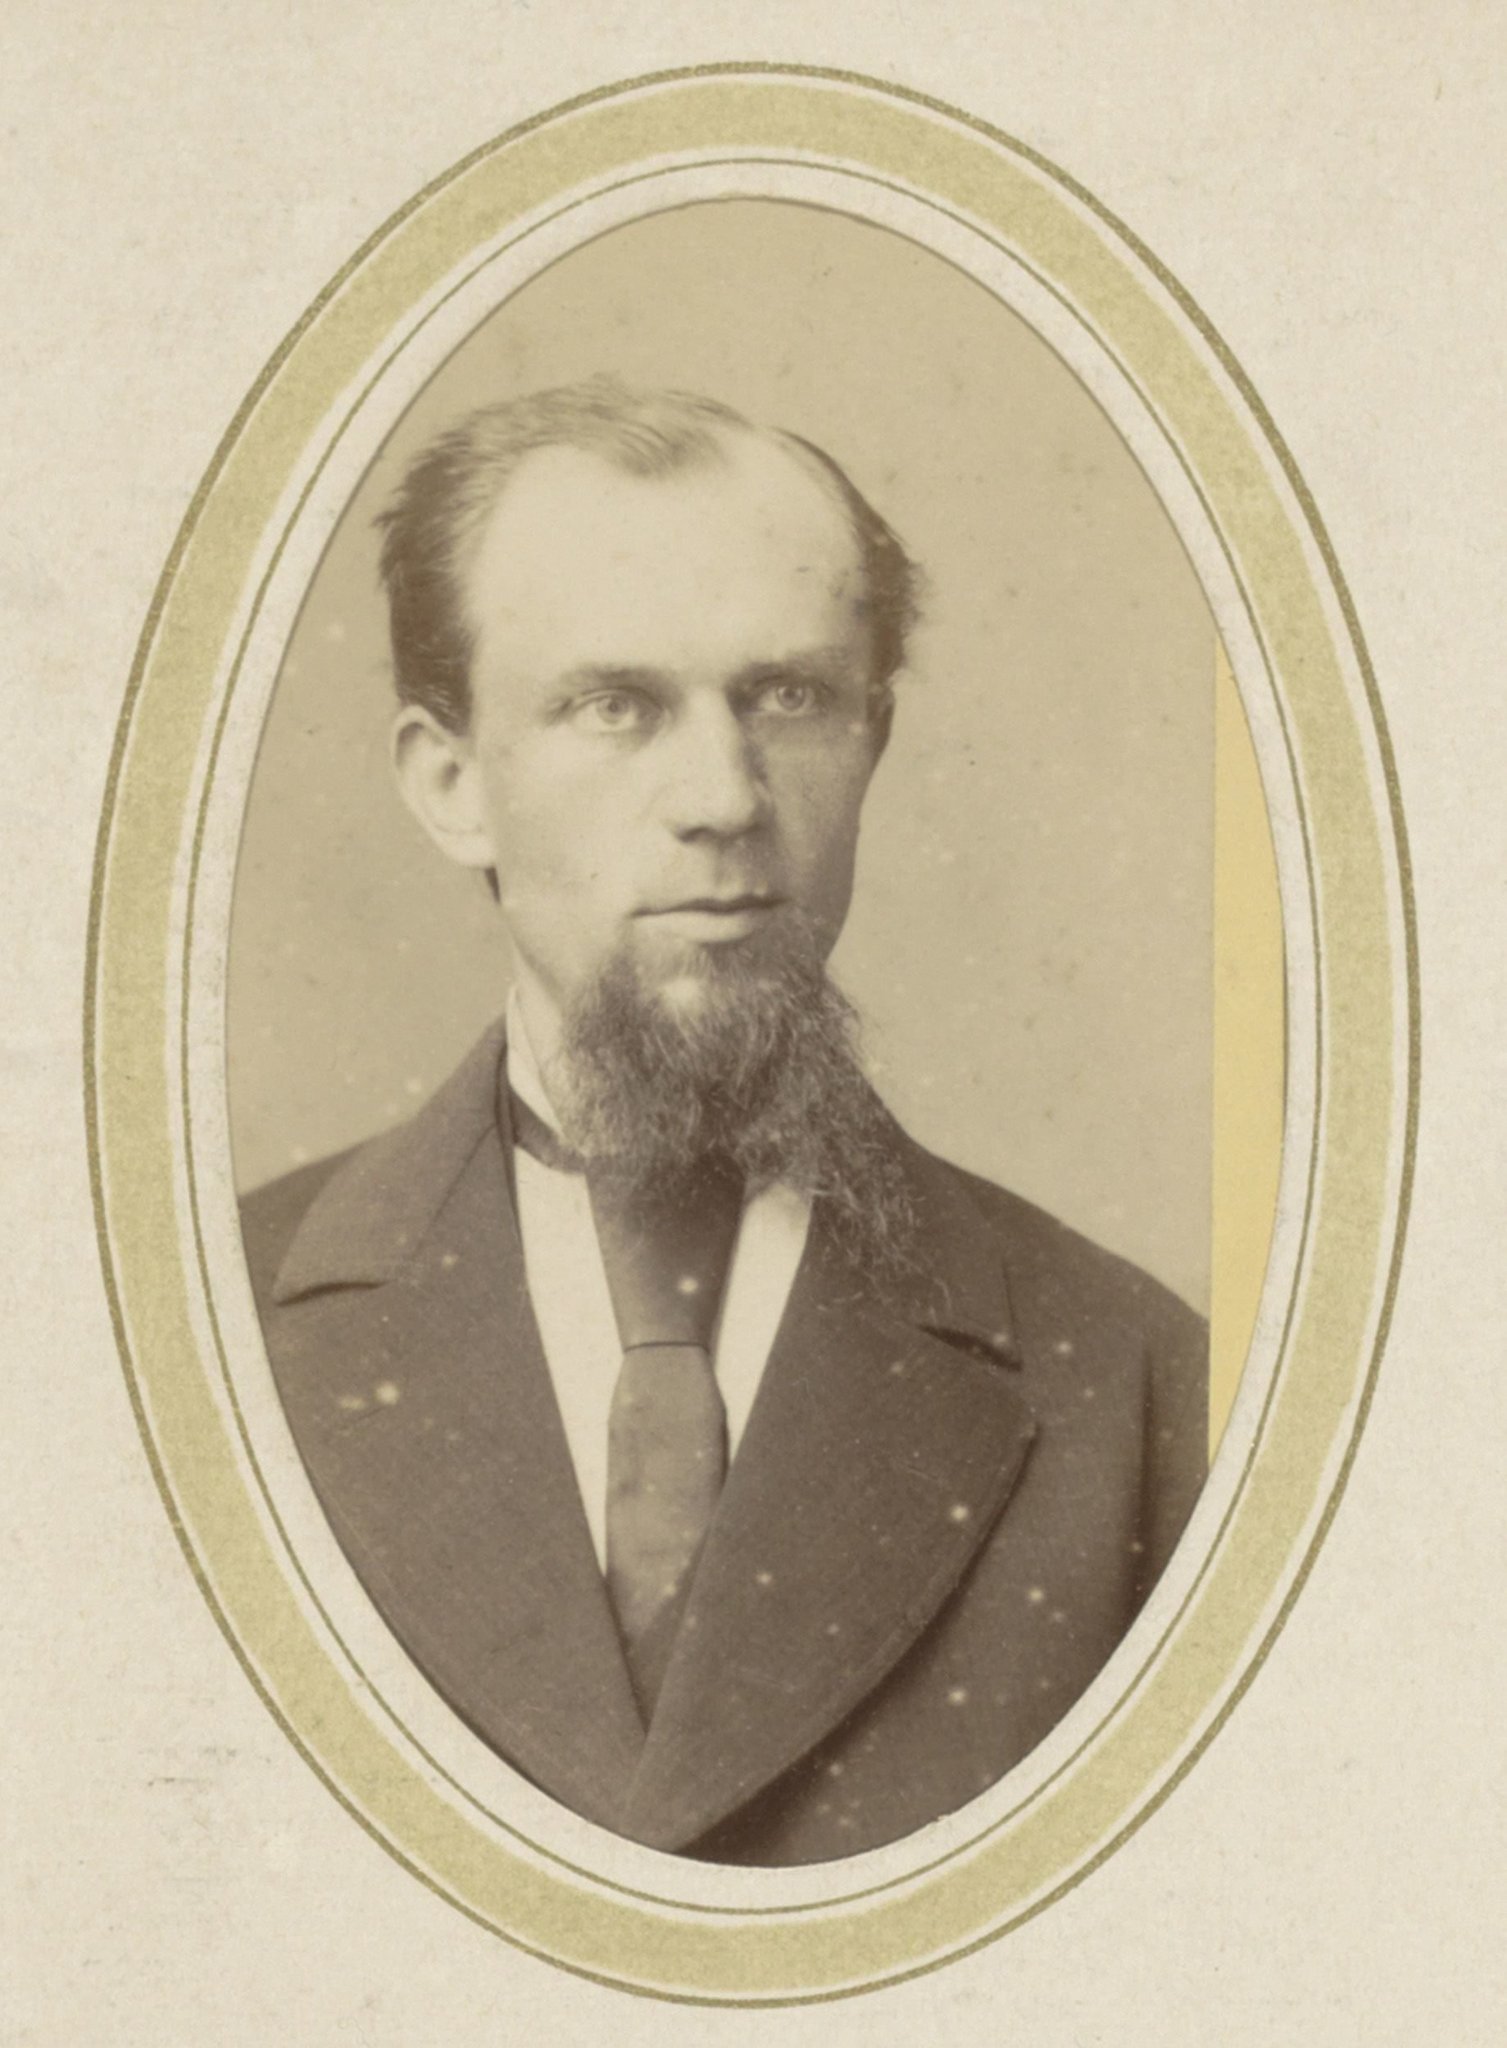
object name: photograph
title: Portret van een man met een baard en een das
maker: johan christiaan reesinck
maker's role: fotograaf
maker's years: 1838-1922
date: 1866-1900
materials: cardboard, paper, photographic support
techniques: albumen print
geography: zutphen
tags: historical persons, neck-gear ~ clothing, clothing for the upper part of the body, beard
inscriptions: address: ‘Zutphen Berkelkade’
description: Onderdeel van Fotoalbum van een Nederlandse familie met 168 cartes-de-visite en kabinetfoto's.